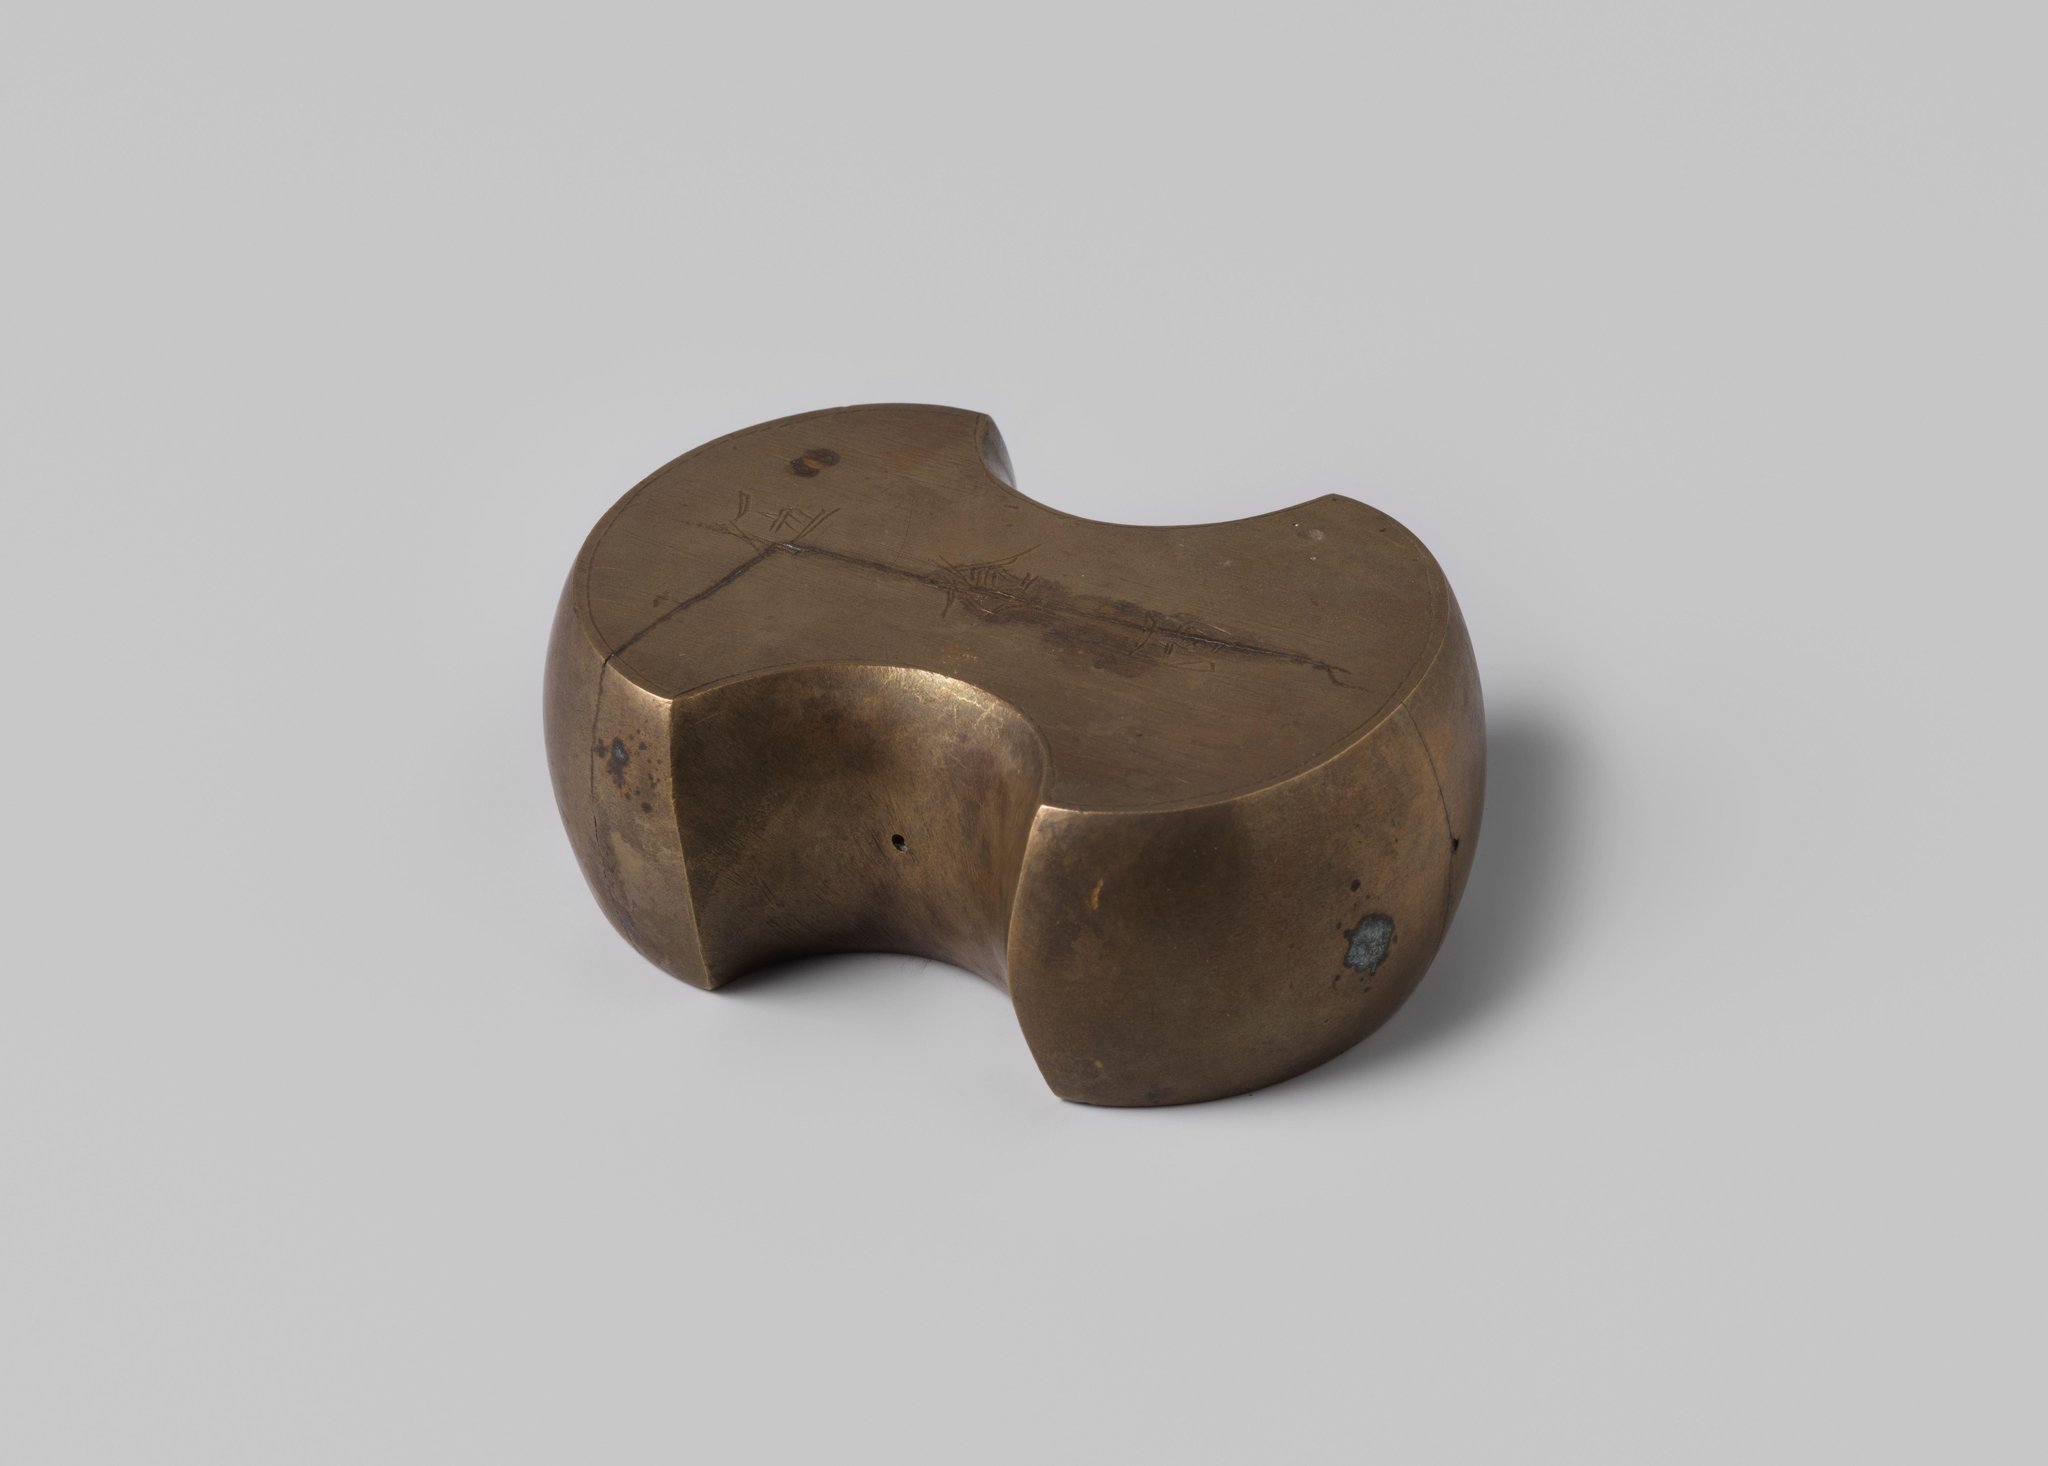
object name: weight scale component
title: Chinese tael weight from the wreck of the Dutch East India ship 't Vliegend Hart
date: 1700-1735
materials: copper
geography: china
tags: 't vliegend hart (schip), verenigde oostindische compagnie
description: Koperen tael- of qiangewicht met Chinese en Europese inscripties waarmee goud en andere kostbaarheden werden gewogen. Vioolgewicht, violin-shaped weights.